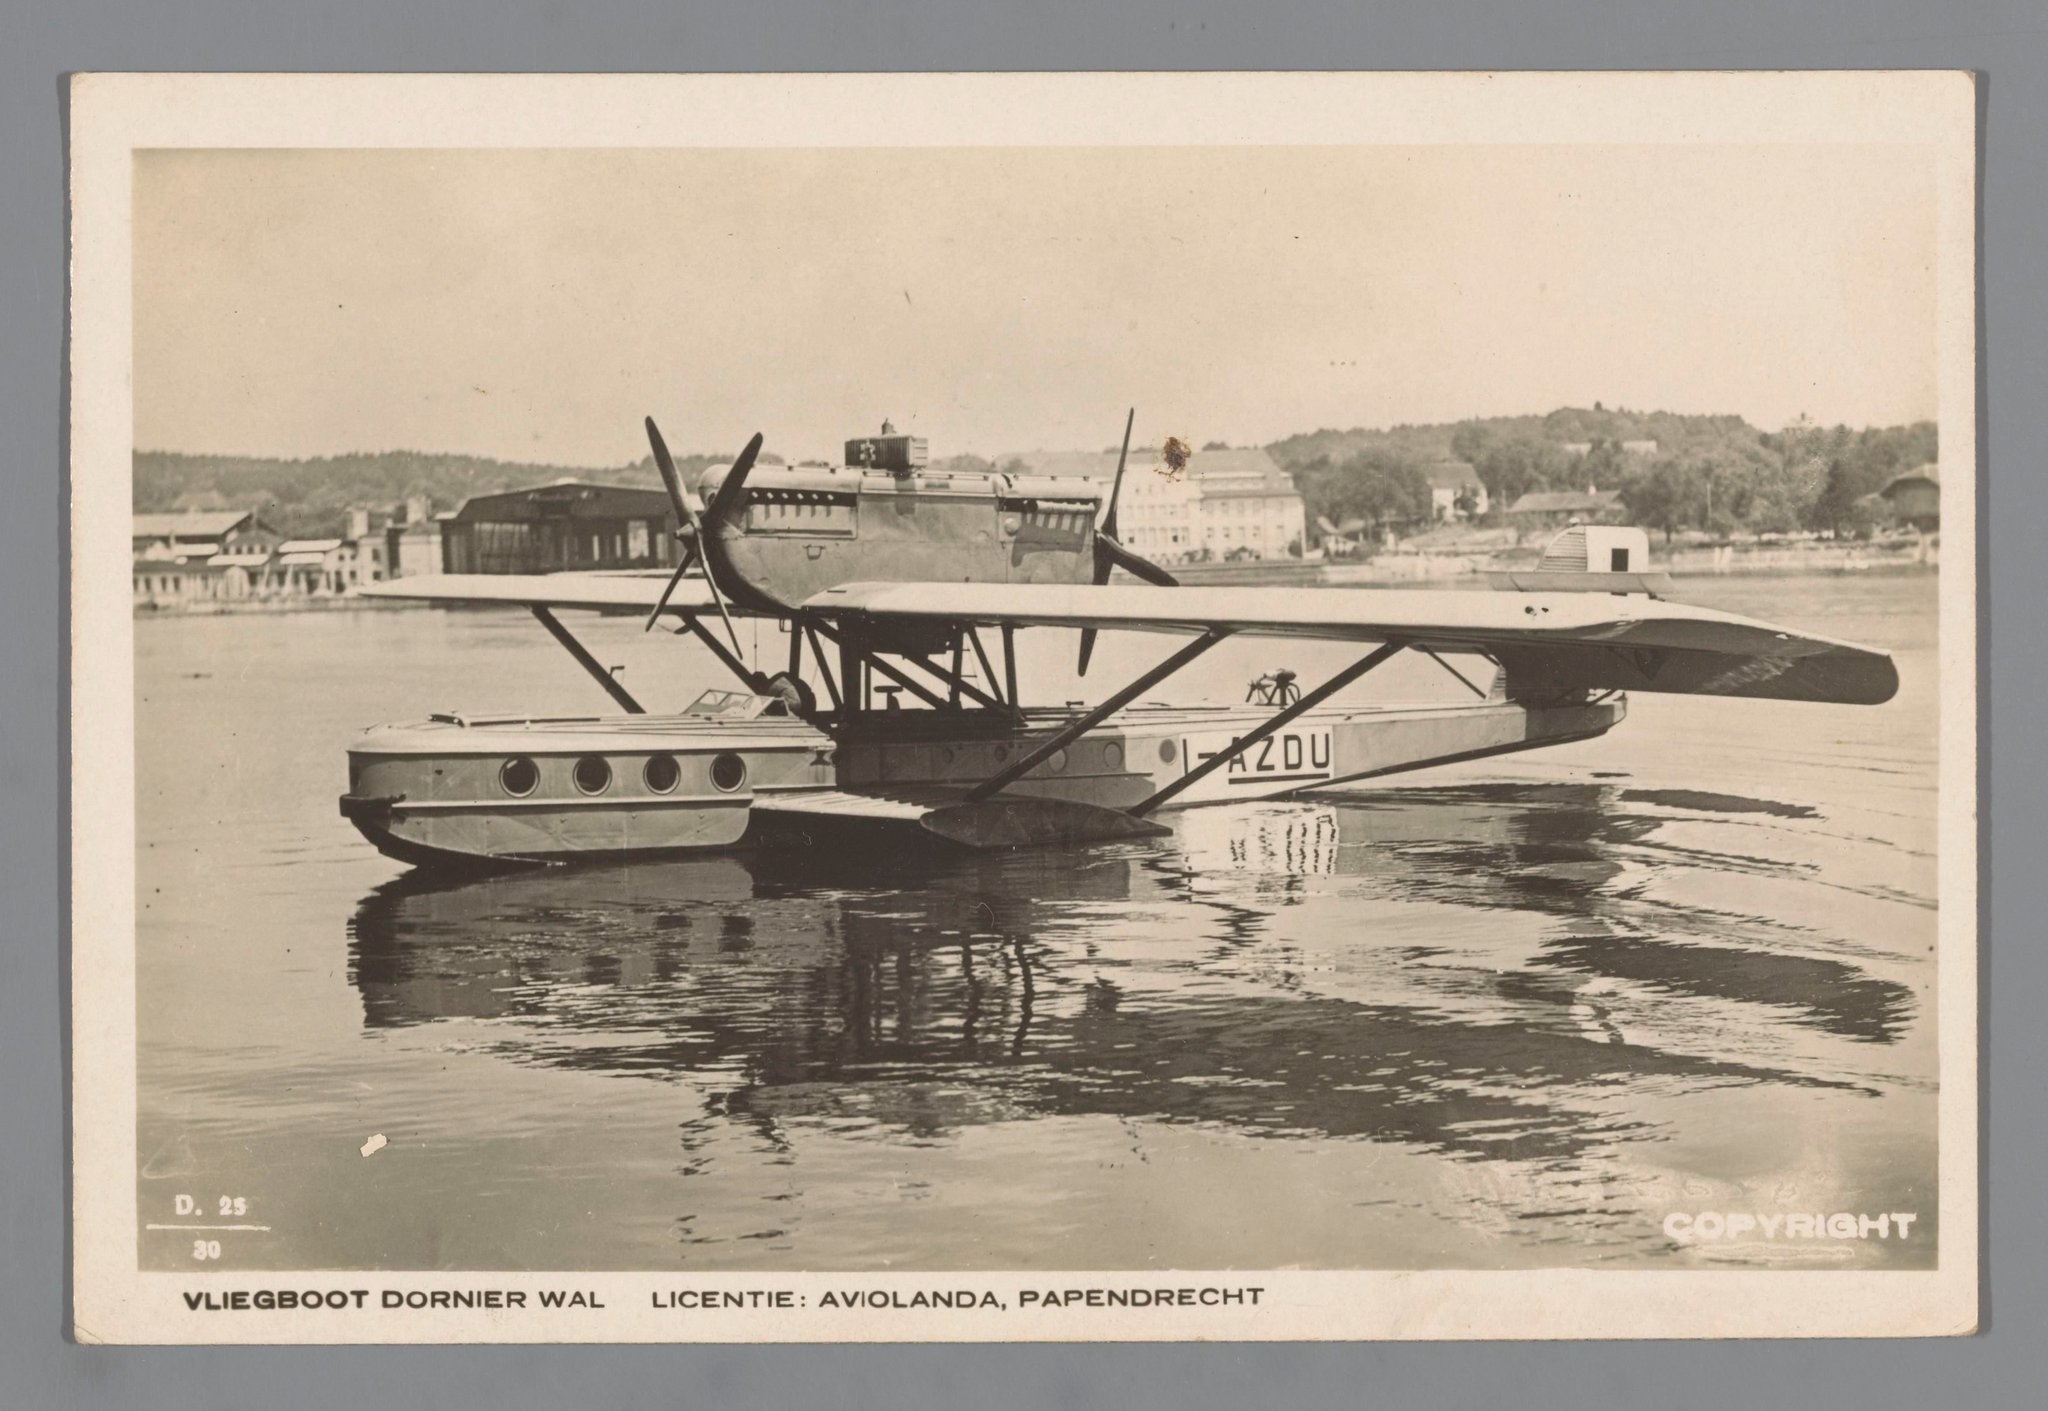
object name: ansichtkaart, prentbriefkaart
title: Vliegboot Dornier Wal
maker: Anonymous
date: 1925-1935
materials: photographic support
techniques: gelatin silver print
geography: netherlands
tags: aircraft, aeroplane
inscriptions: inscription: ‘Copyright Koninklijke Luchtvaart Maatschappij Fototechnische Dienst Rotterdam’, inscription: ‘Licentie: Aviolanda, Papendrecht’